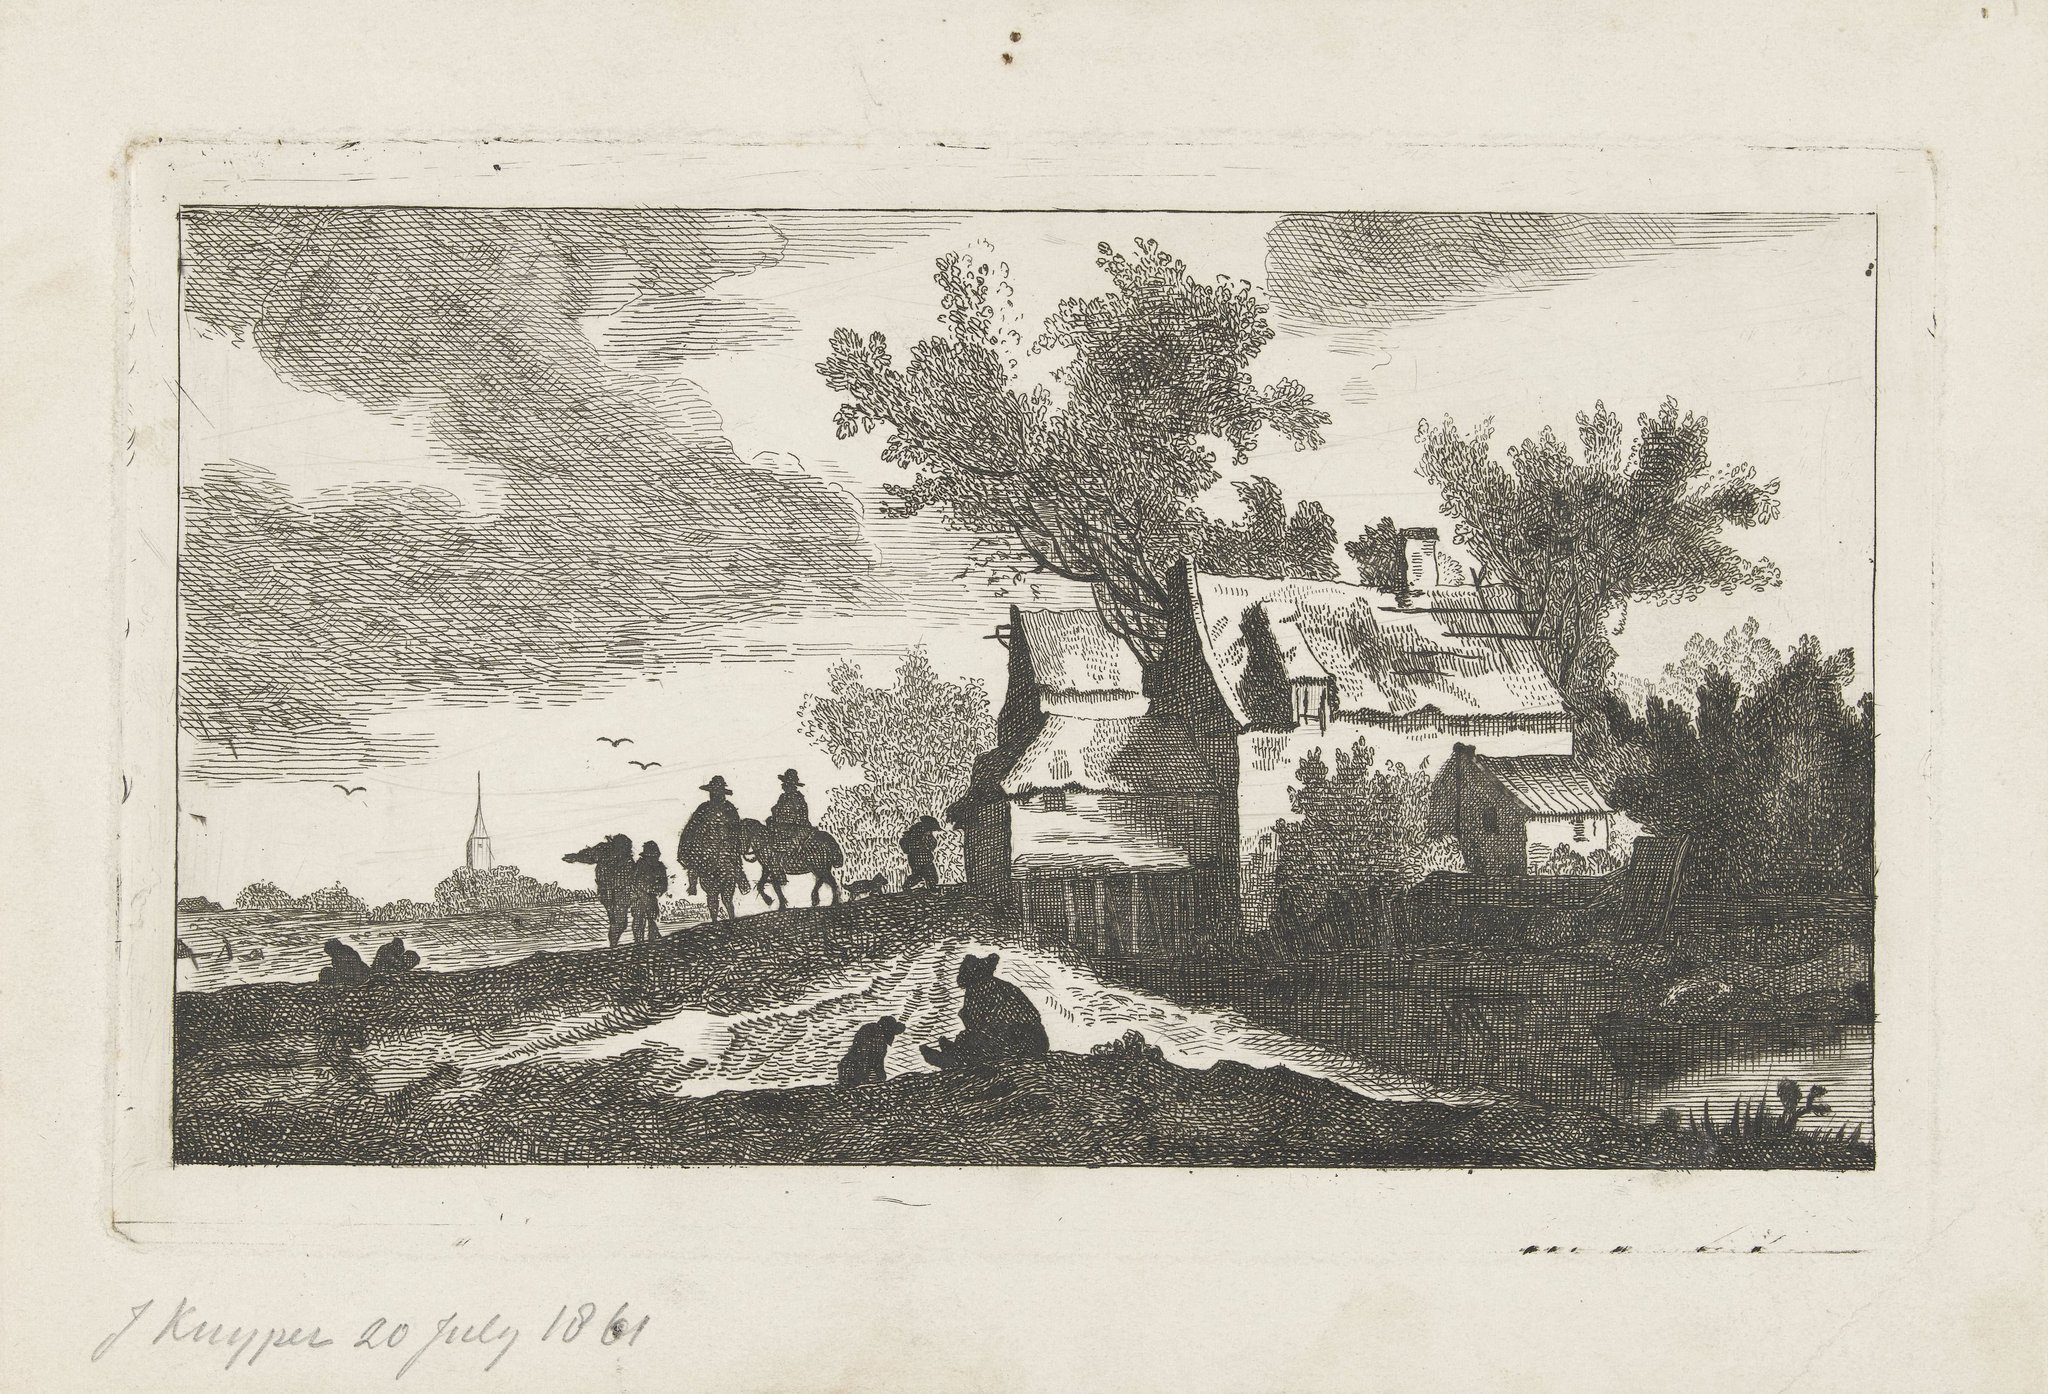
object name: print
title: Verlaten huis en ruiters, bij nacht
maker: j. kuyper (prentmaker)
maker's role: print maker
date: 1861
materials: paper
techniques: etching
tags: riding a horse, ass, or mule; rider, horseman, church (exterior), farm or solitary house in landscape, dog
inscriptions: inscription: ‘J Kuyper 20 July 1861’, collector's mark: Lugt 2228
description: Gezicht op een heuvelachtig landschap met een verlaten huis, bij nacht. Bij het huis bevinden zich verschillende figuren, waaronder twee ruiters. Op de achtergrond zijn de contouren van een dorp en de dorpskerk te zien.